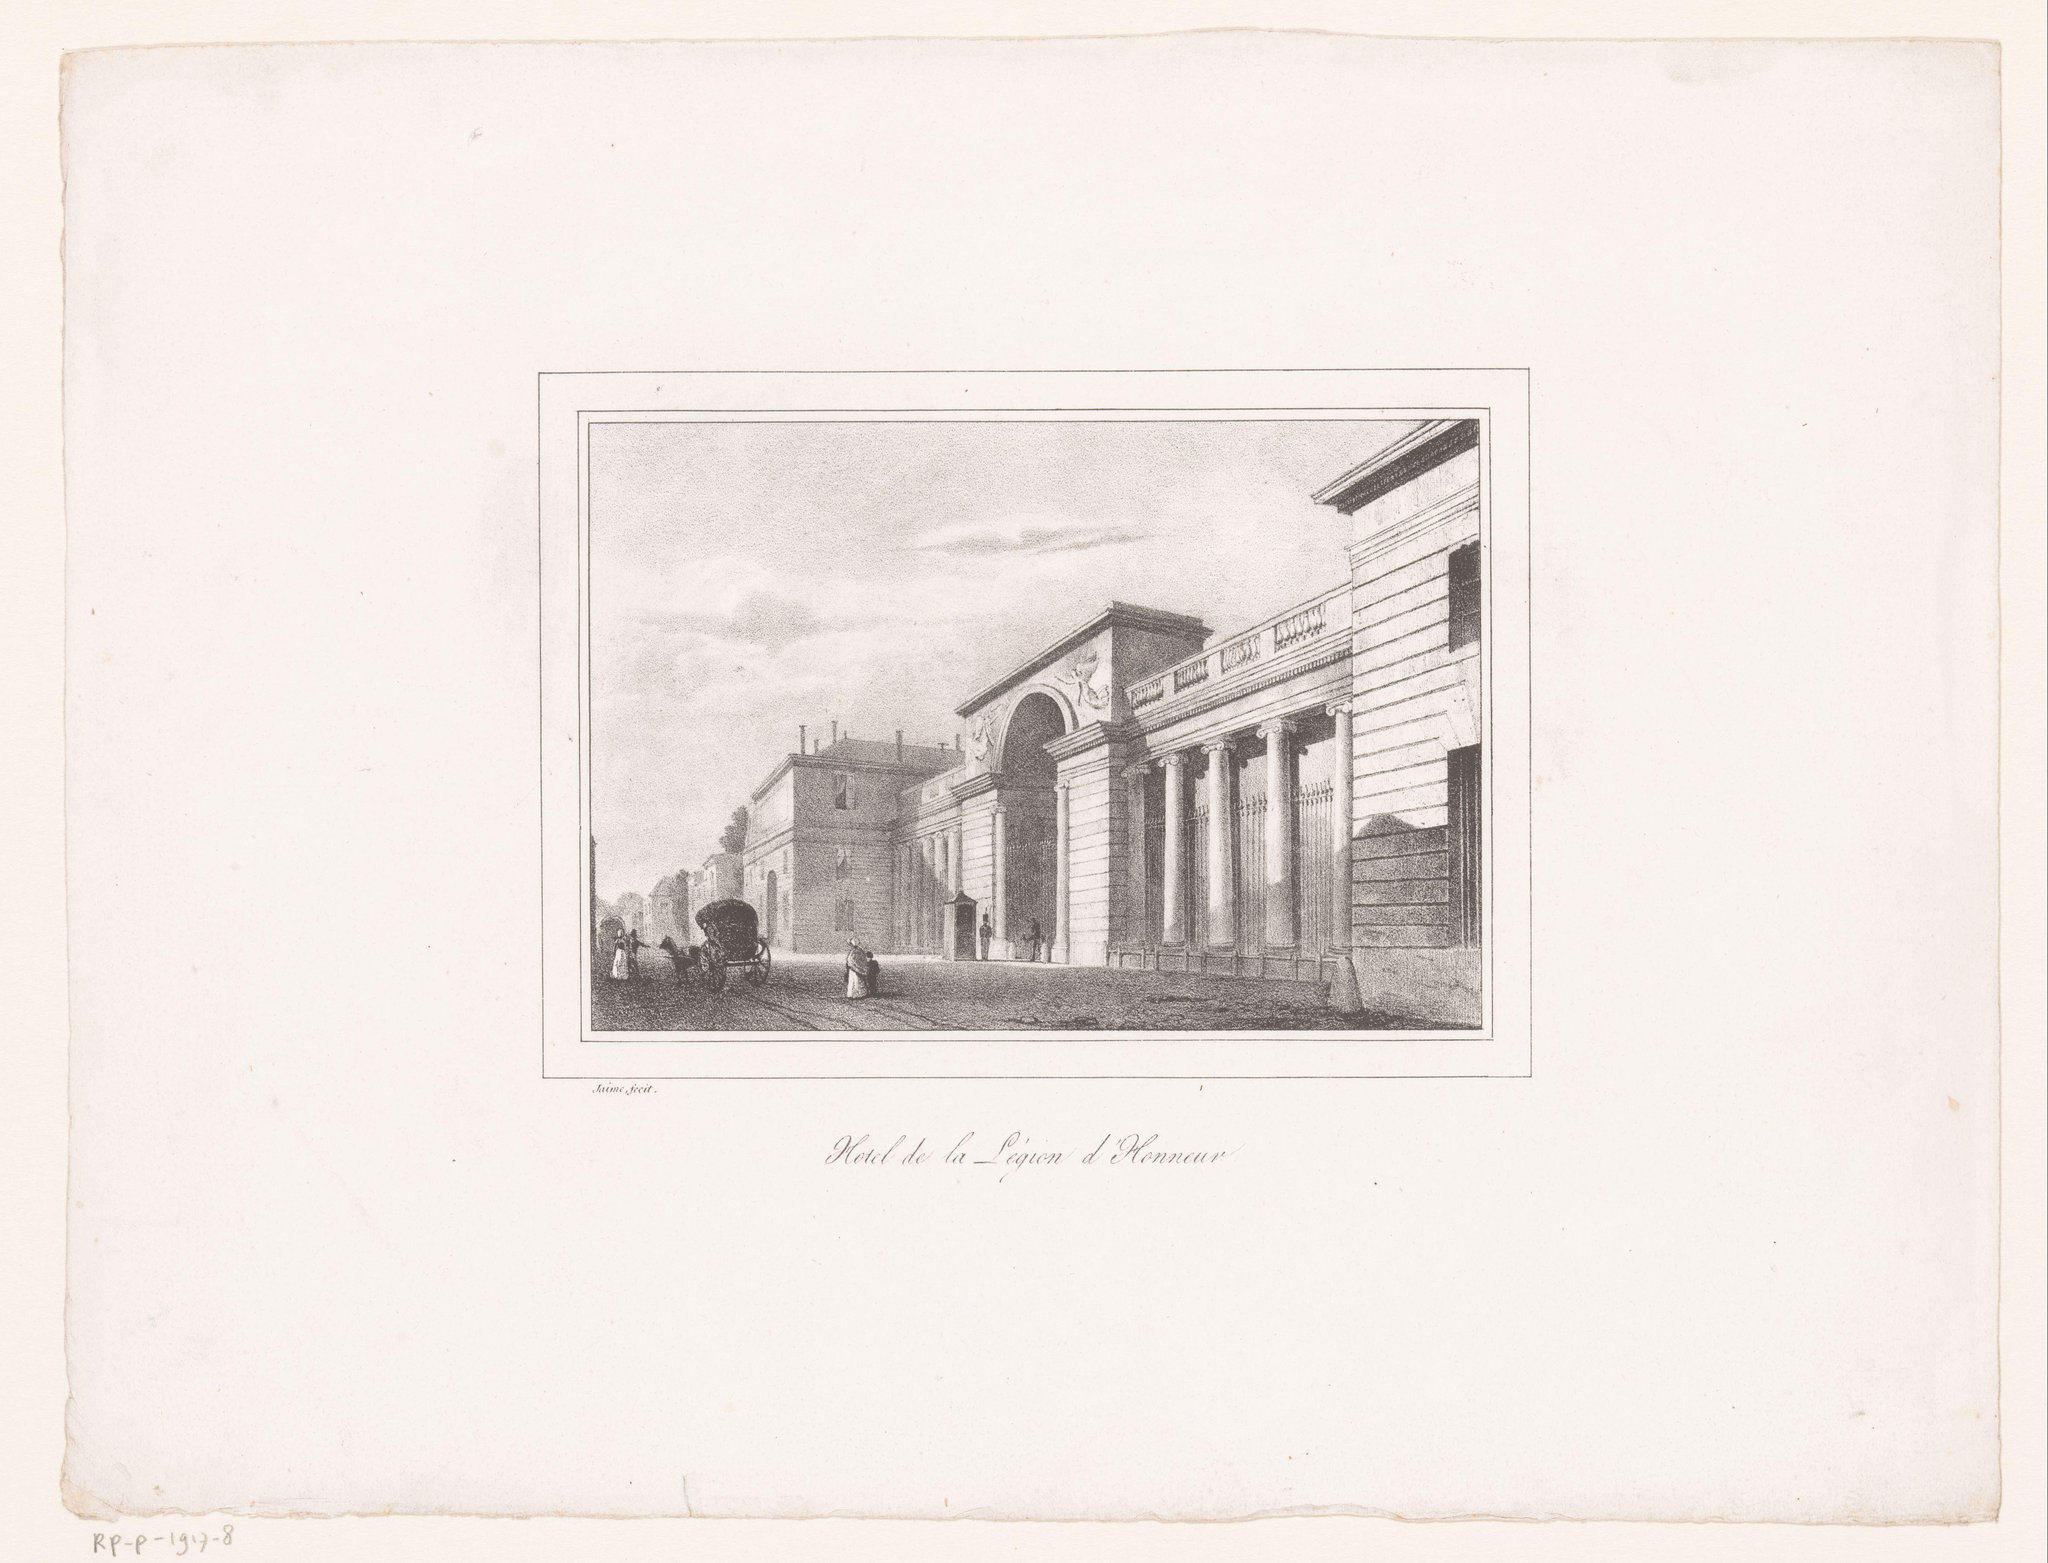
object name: print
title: Hôtel de la Légion d'Honneur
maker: ernest jaime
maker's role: print maker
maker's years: 1802-1884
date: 1812-1884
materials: paper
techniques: lithograph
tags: palace, paris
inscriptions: collector's mark: Lugt 2228